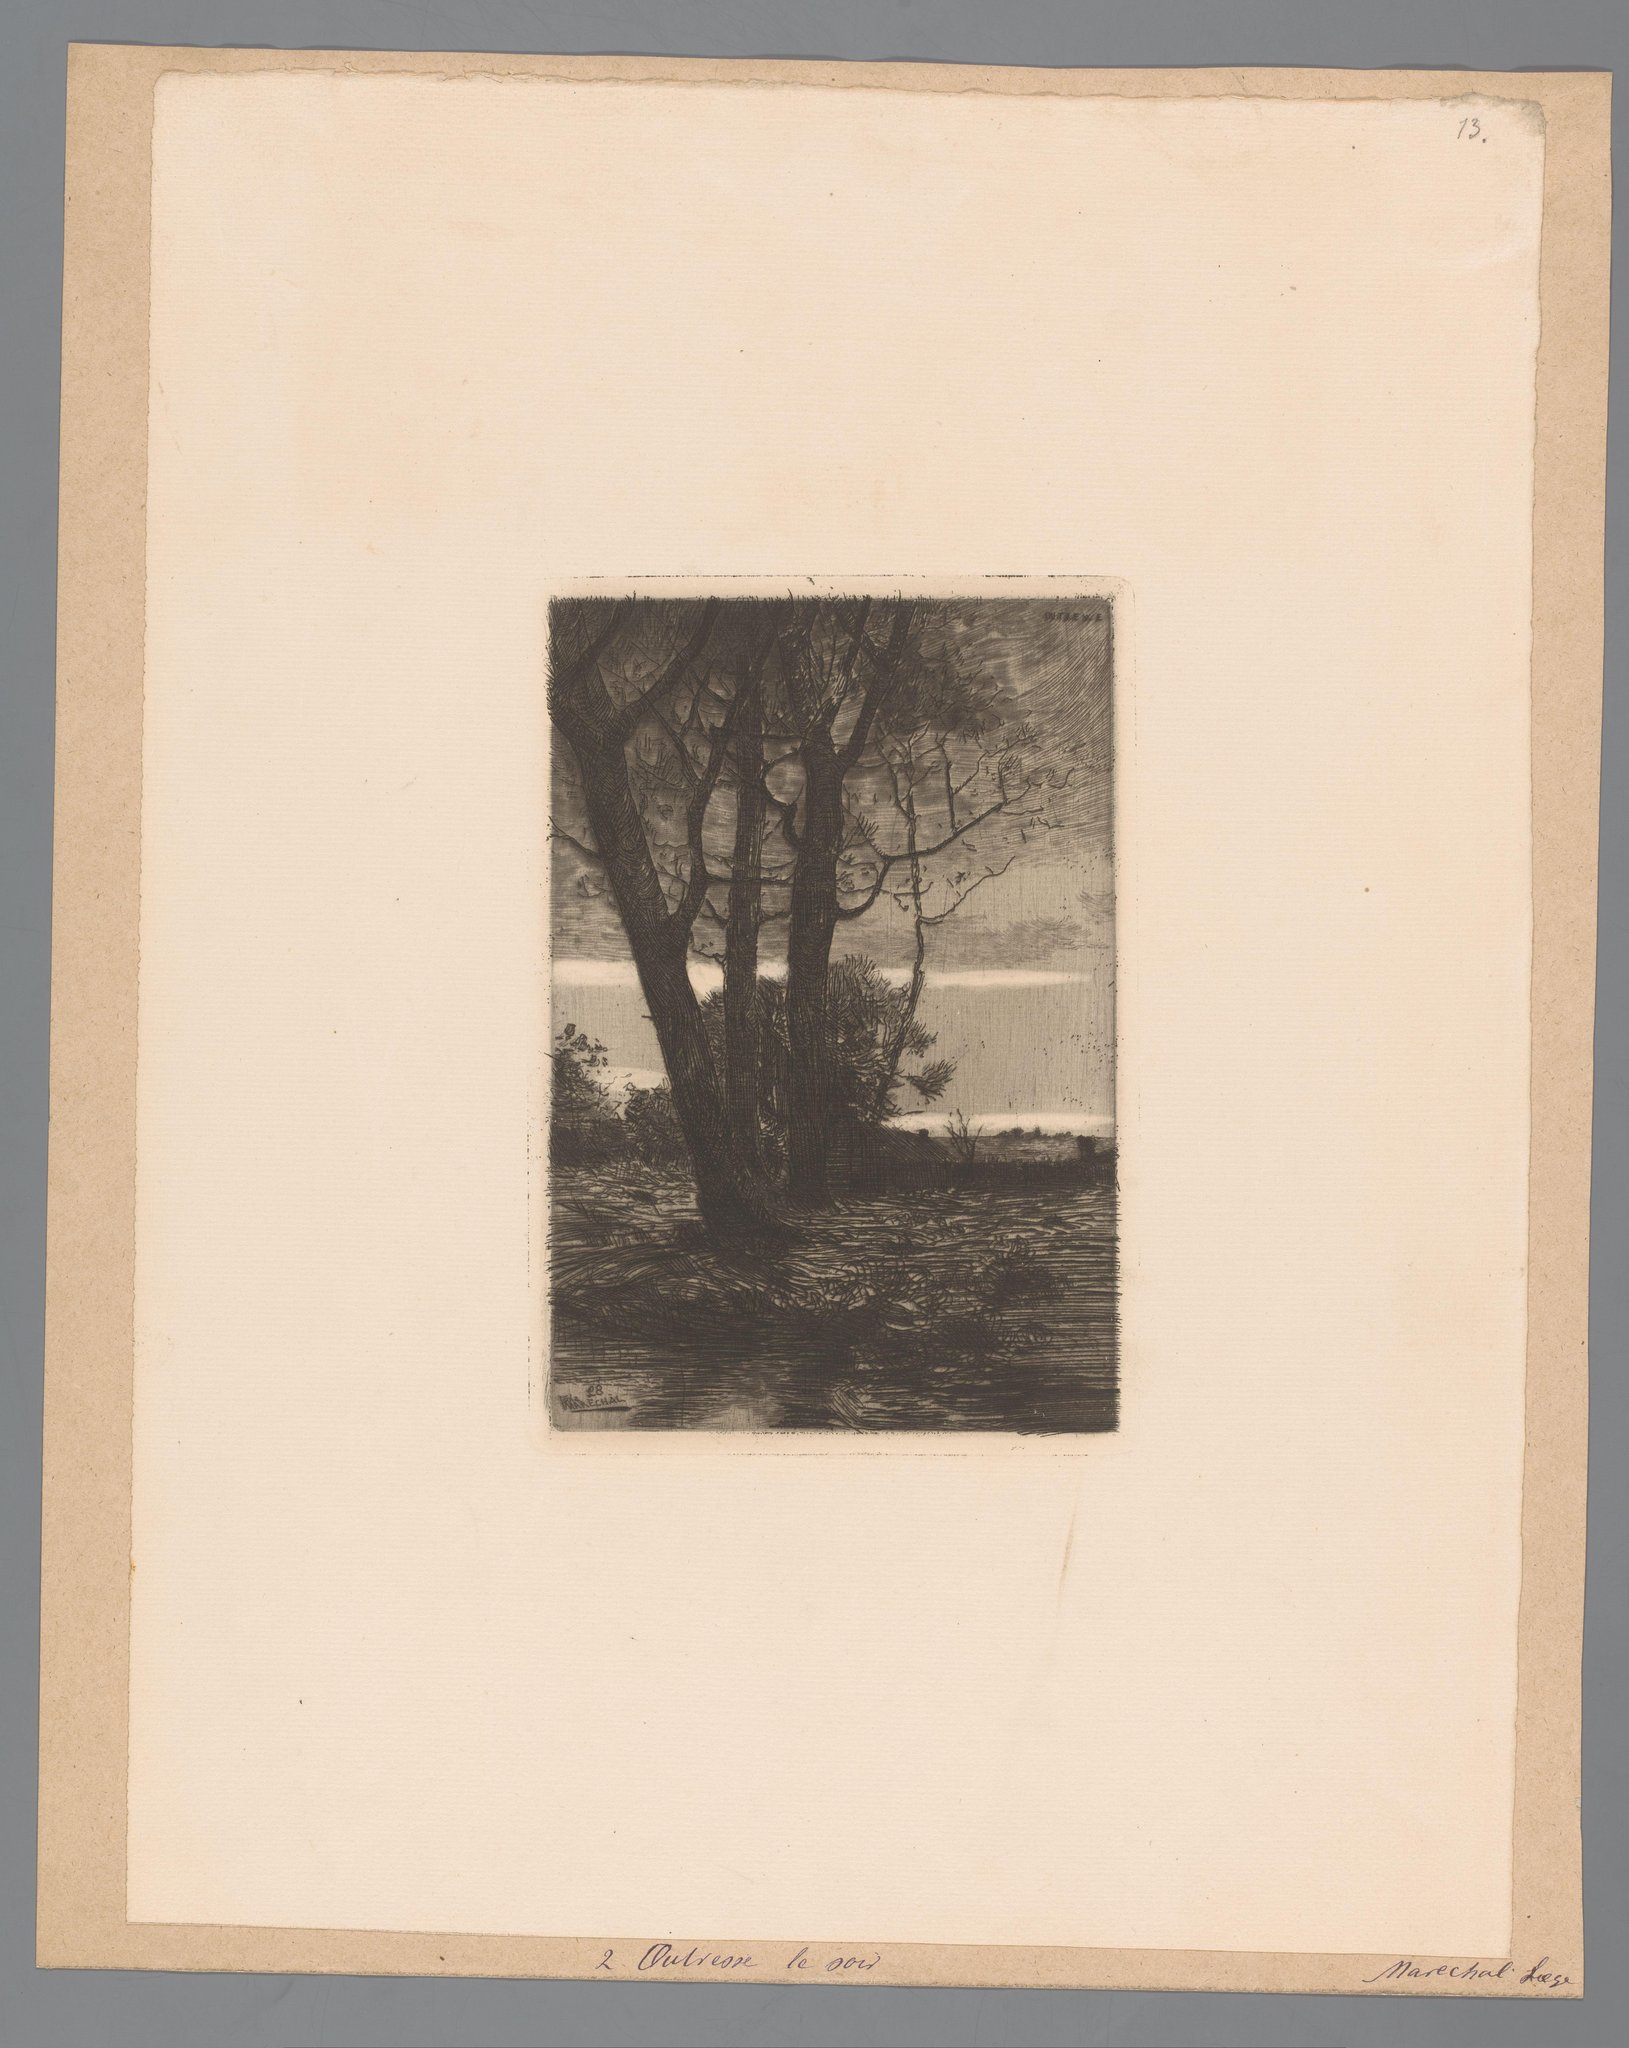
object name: print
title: Landschap met bomen bij avond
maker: françois maréchal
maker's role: print maker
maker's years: 1861-1945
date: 1889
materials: paper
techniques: drypoint, etching, intaglio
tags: landscapes, farm or solitary house in landscape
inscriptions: collector's mark: Lugt 2228